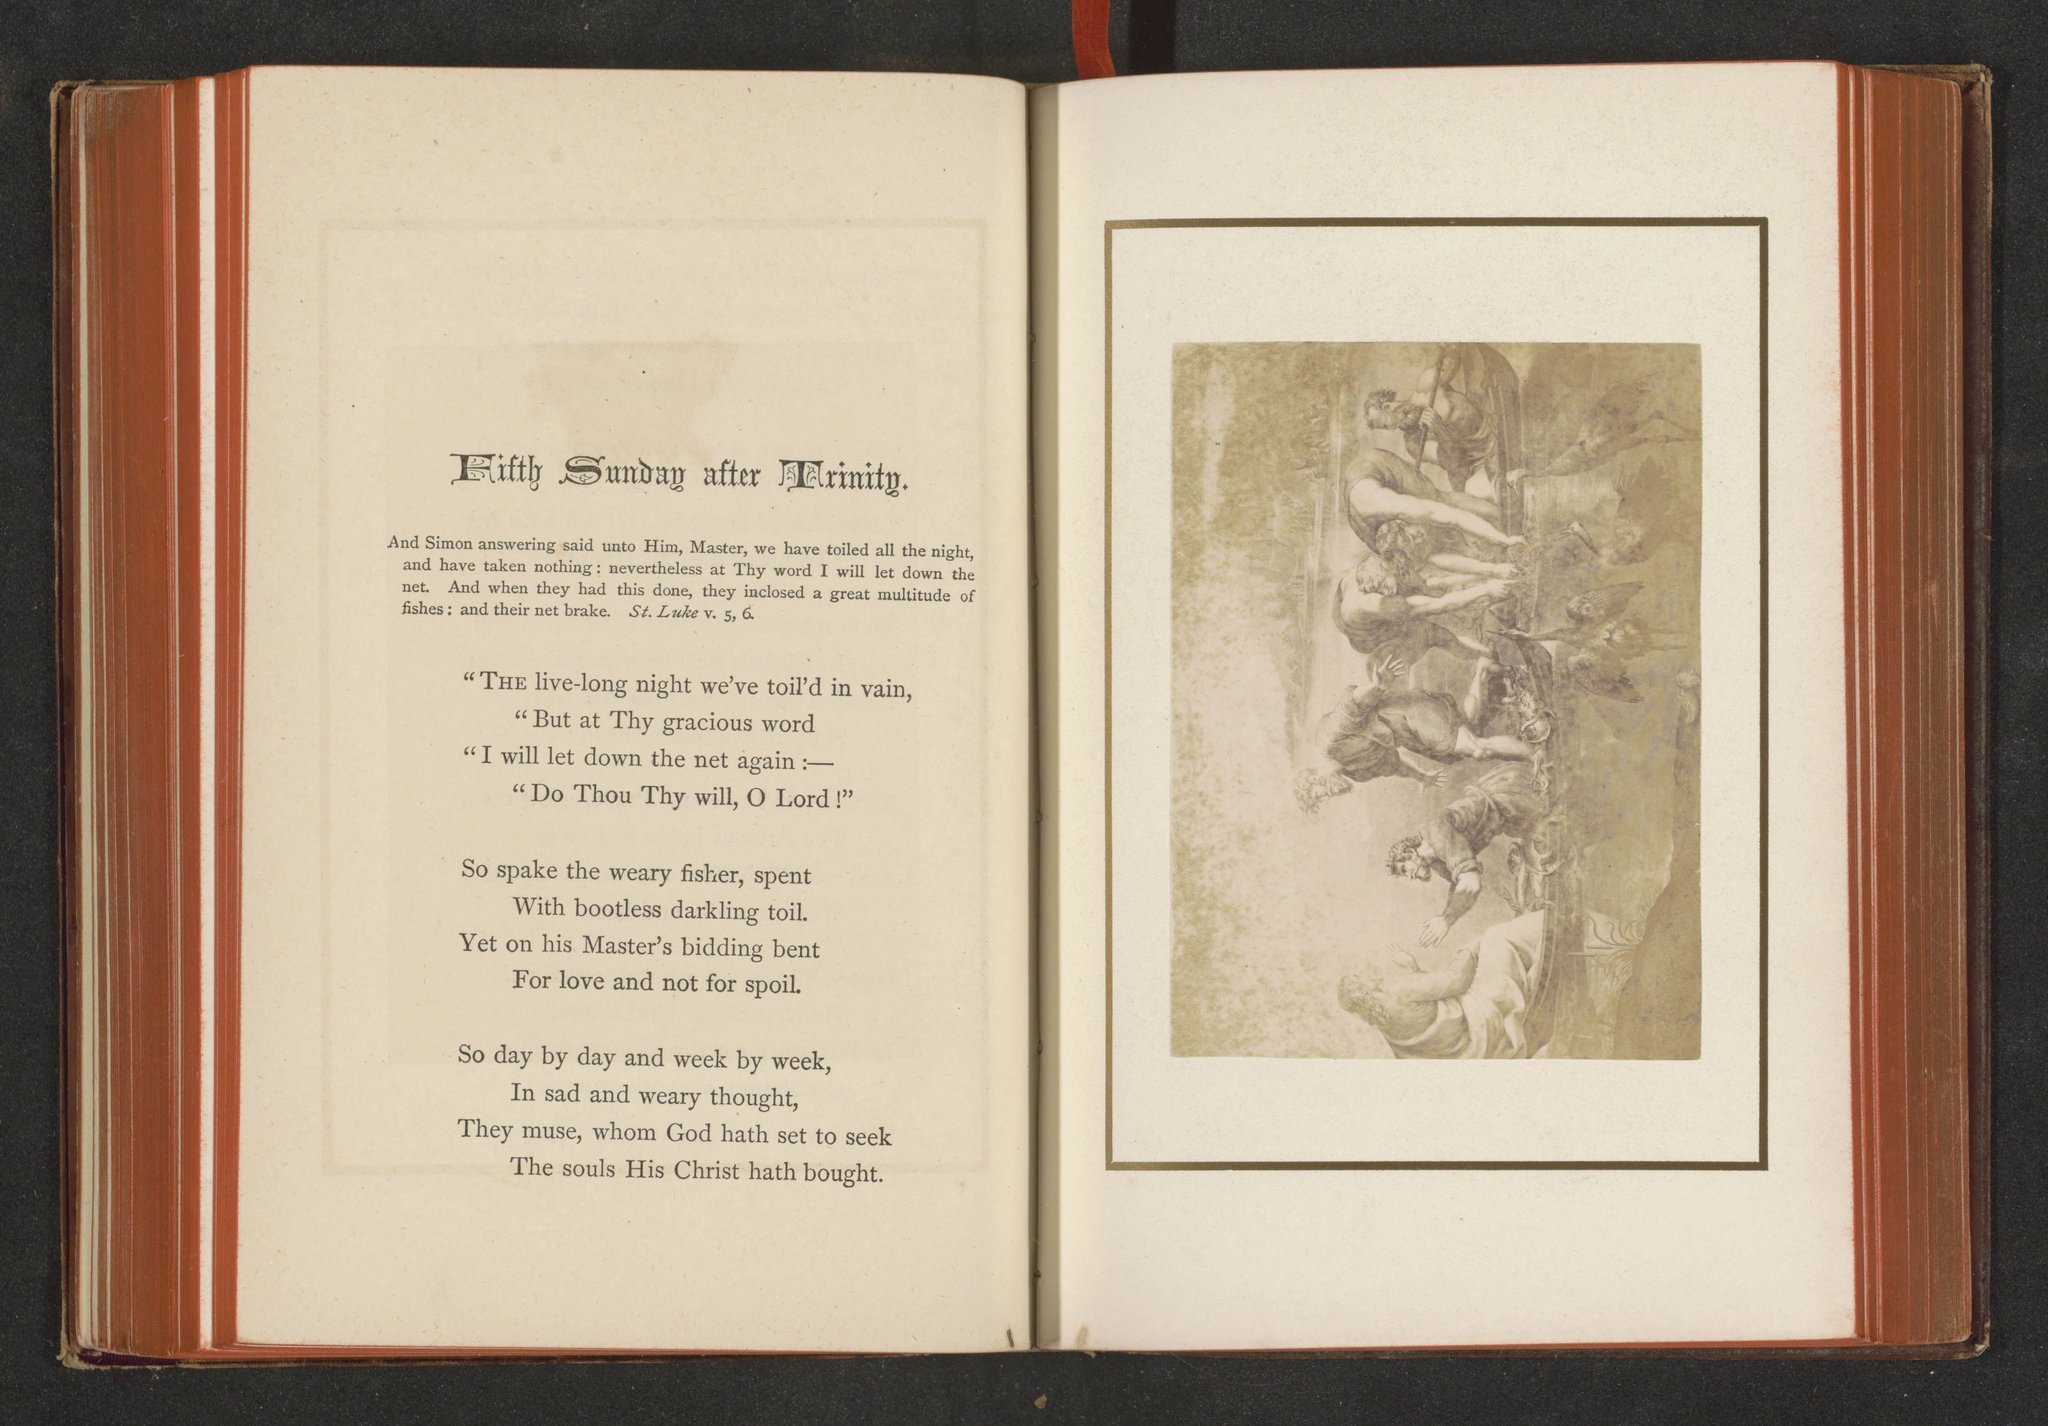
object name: photograph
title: Fotoreproductie van een prent, voorstellende de wonderbaarlijke visvangst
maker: Anonymous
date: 1870-1875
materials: photographic support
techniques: albumen print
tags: appearance of christ at the lake of gennesaret (sea of galilee, sea of tiberias): miraculous draught of fishes (after the resurrection)